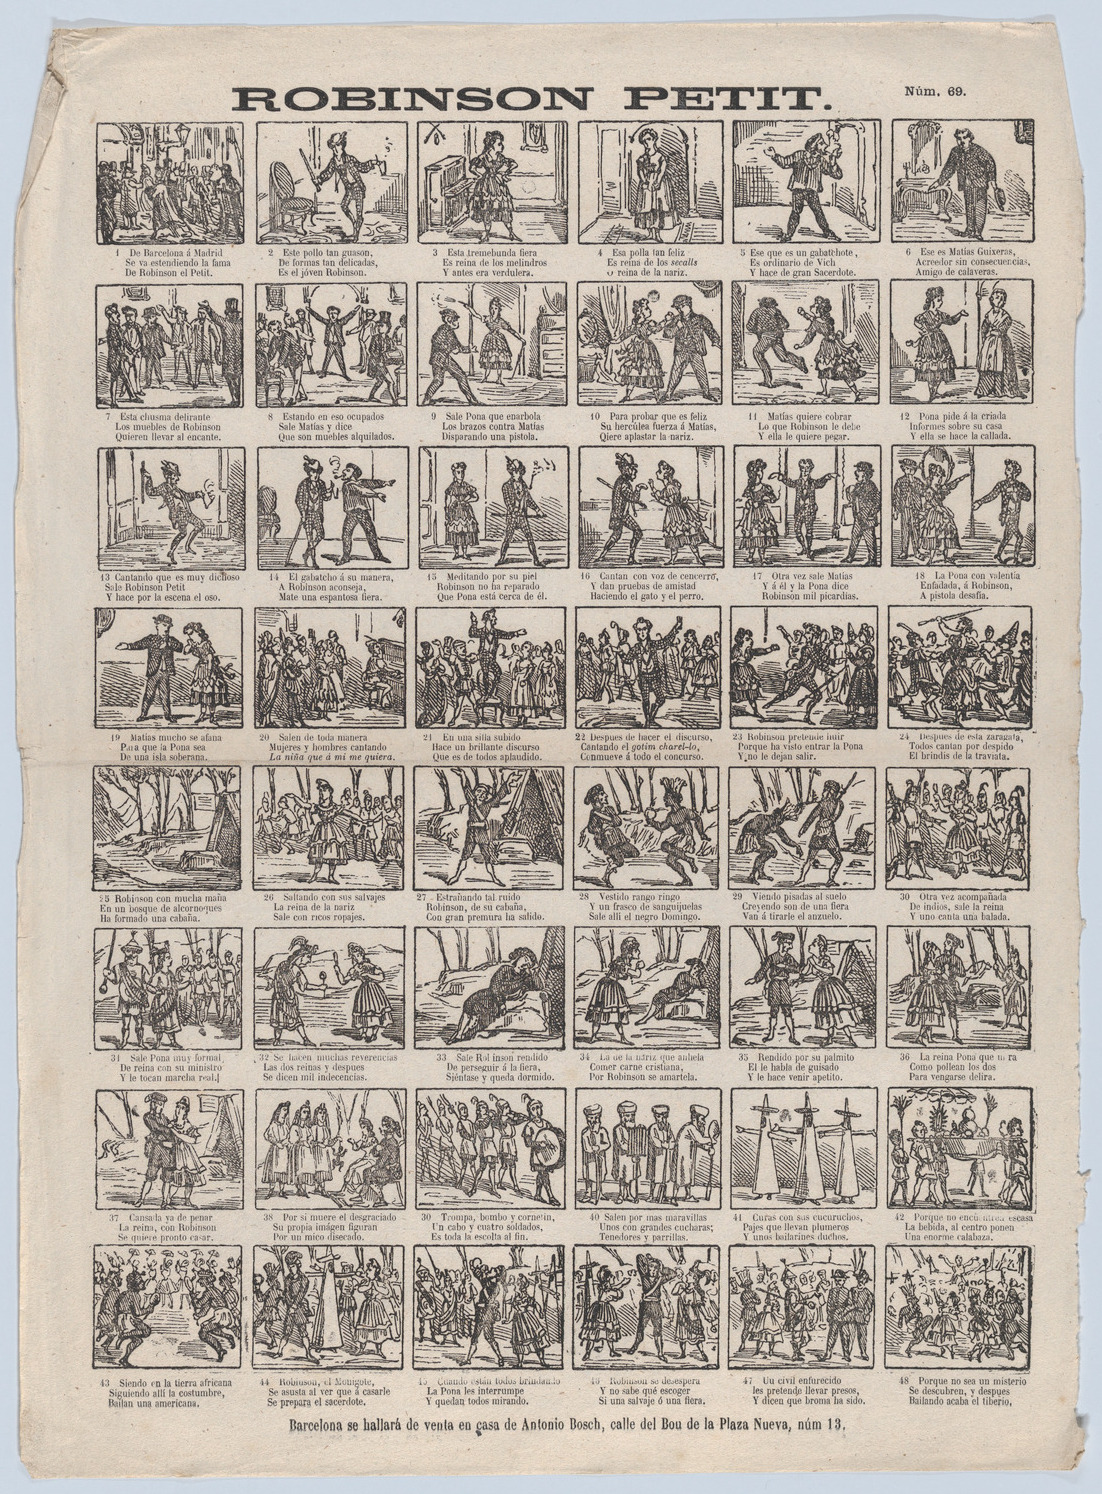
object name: print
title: Broadside with 48 scenes depicting the story of Little Robinson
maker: antonio bosch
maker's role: publisher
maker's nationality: spanish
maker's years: 1860-1880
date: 1860-1870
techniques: etching, lithograph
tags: men,women